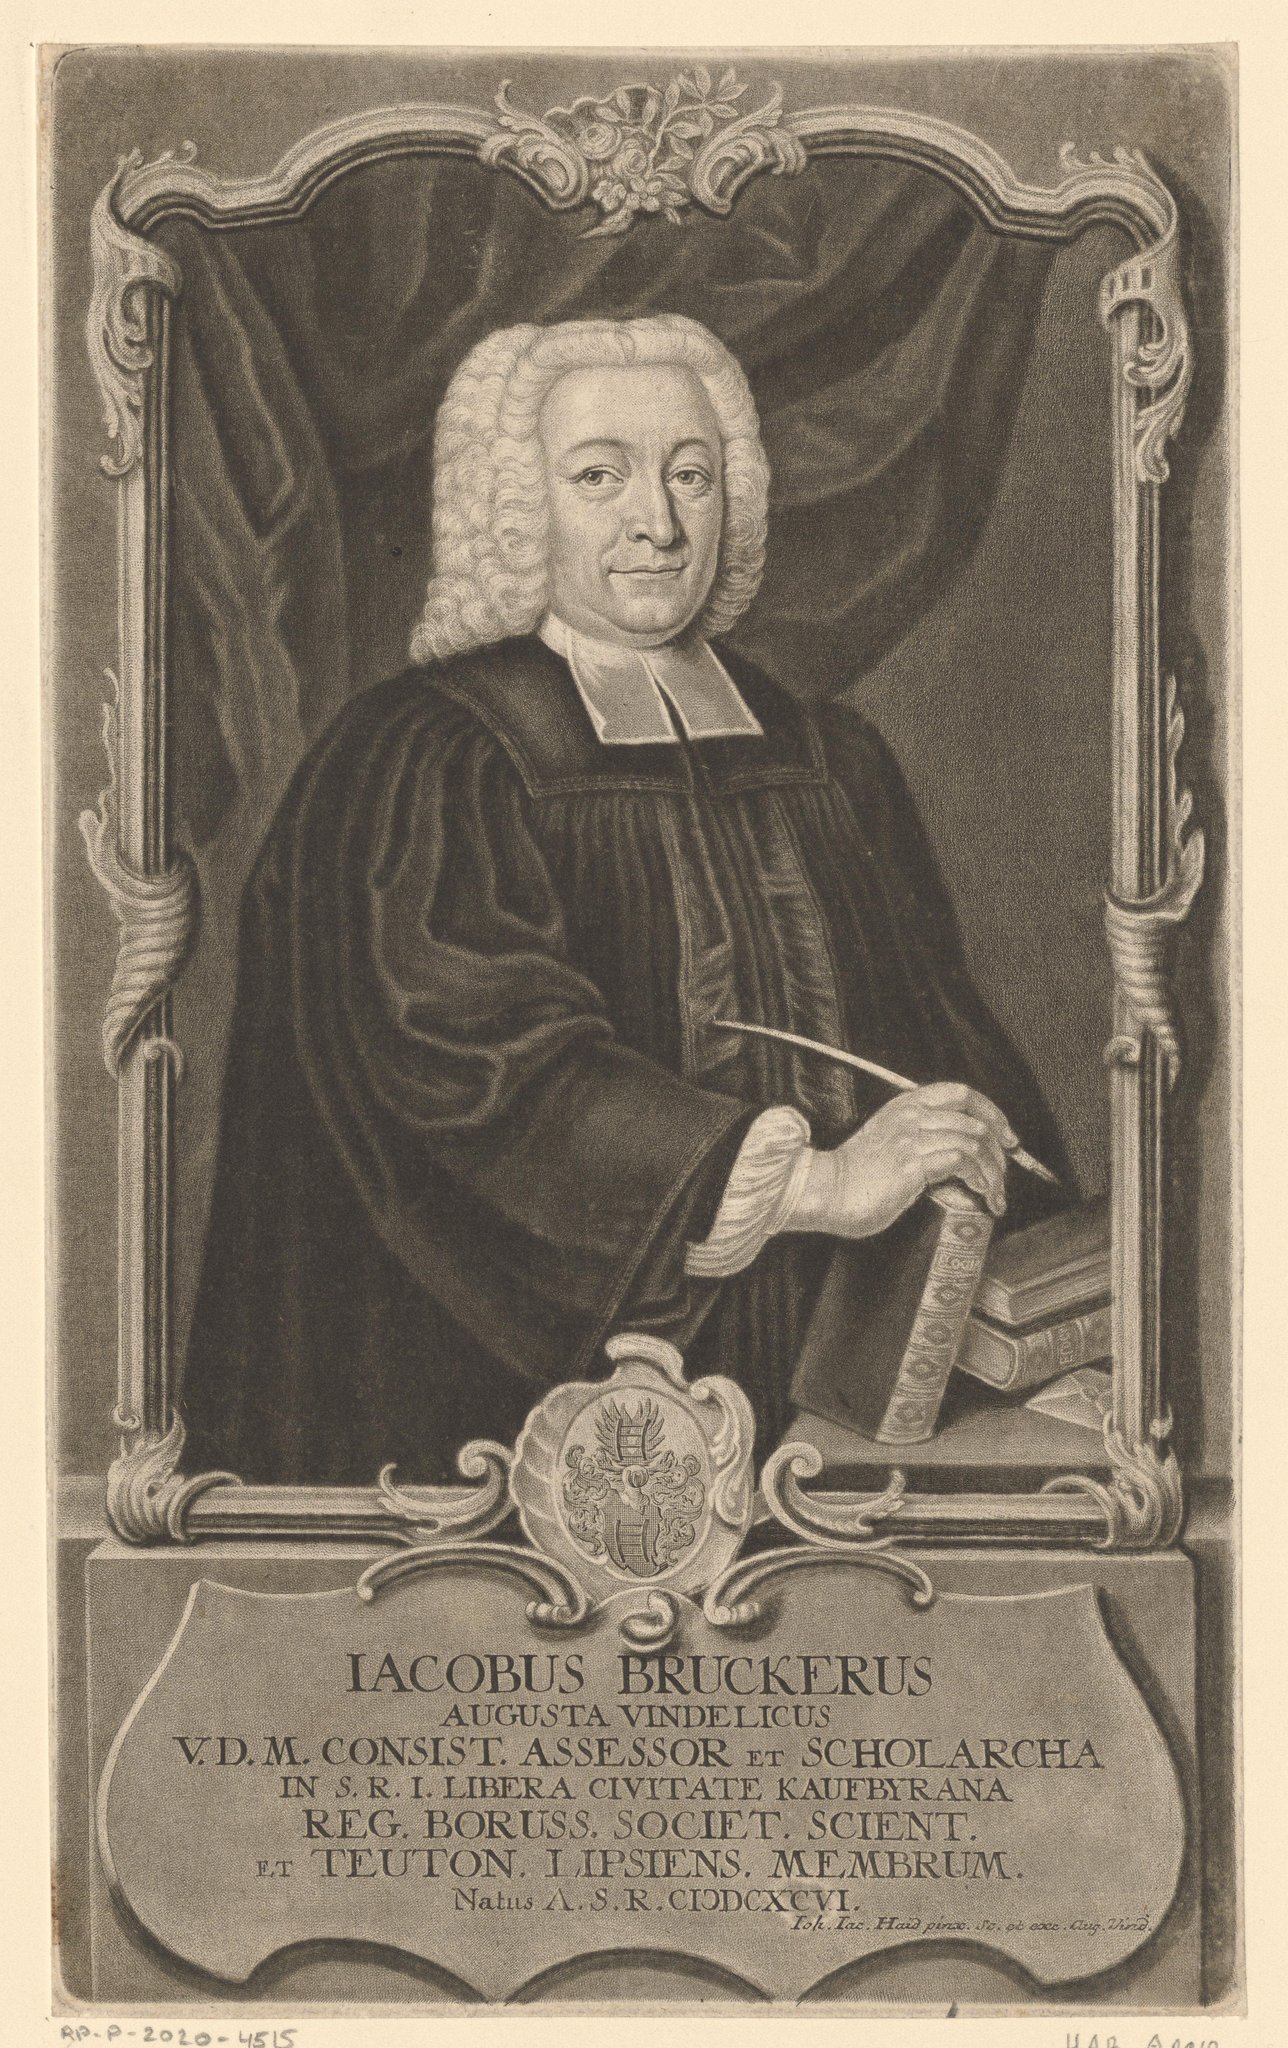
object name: print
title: Portret van Jacob Brucker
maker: johann jacob haid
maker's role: print maker, publisher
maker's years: 1704-1767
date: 1724-1767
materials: paper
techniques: engraving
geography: augsburg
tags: augsburg, jacob brucker, theologian, historical persons, book, armorial bearing, heraldry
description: Andere staat van de prent verschenen in: Brucker, Jacob. Bilder-sal heutiges Tages lebender und durch Gelahrheit berühmter Schrifft-steller. Augsburg: Johann Jacob Haid, 1741.